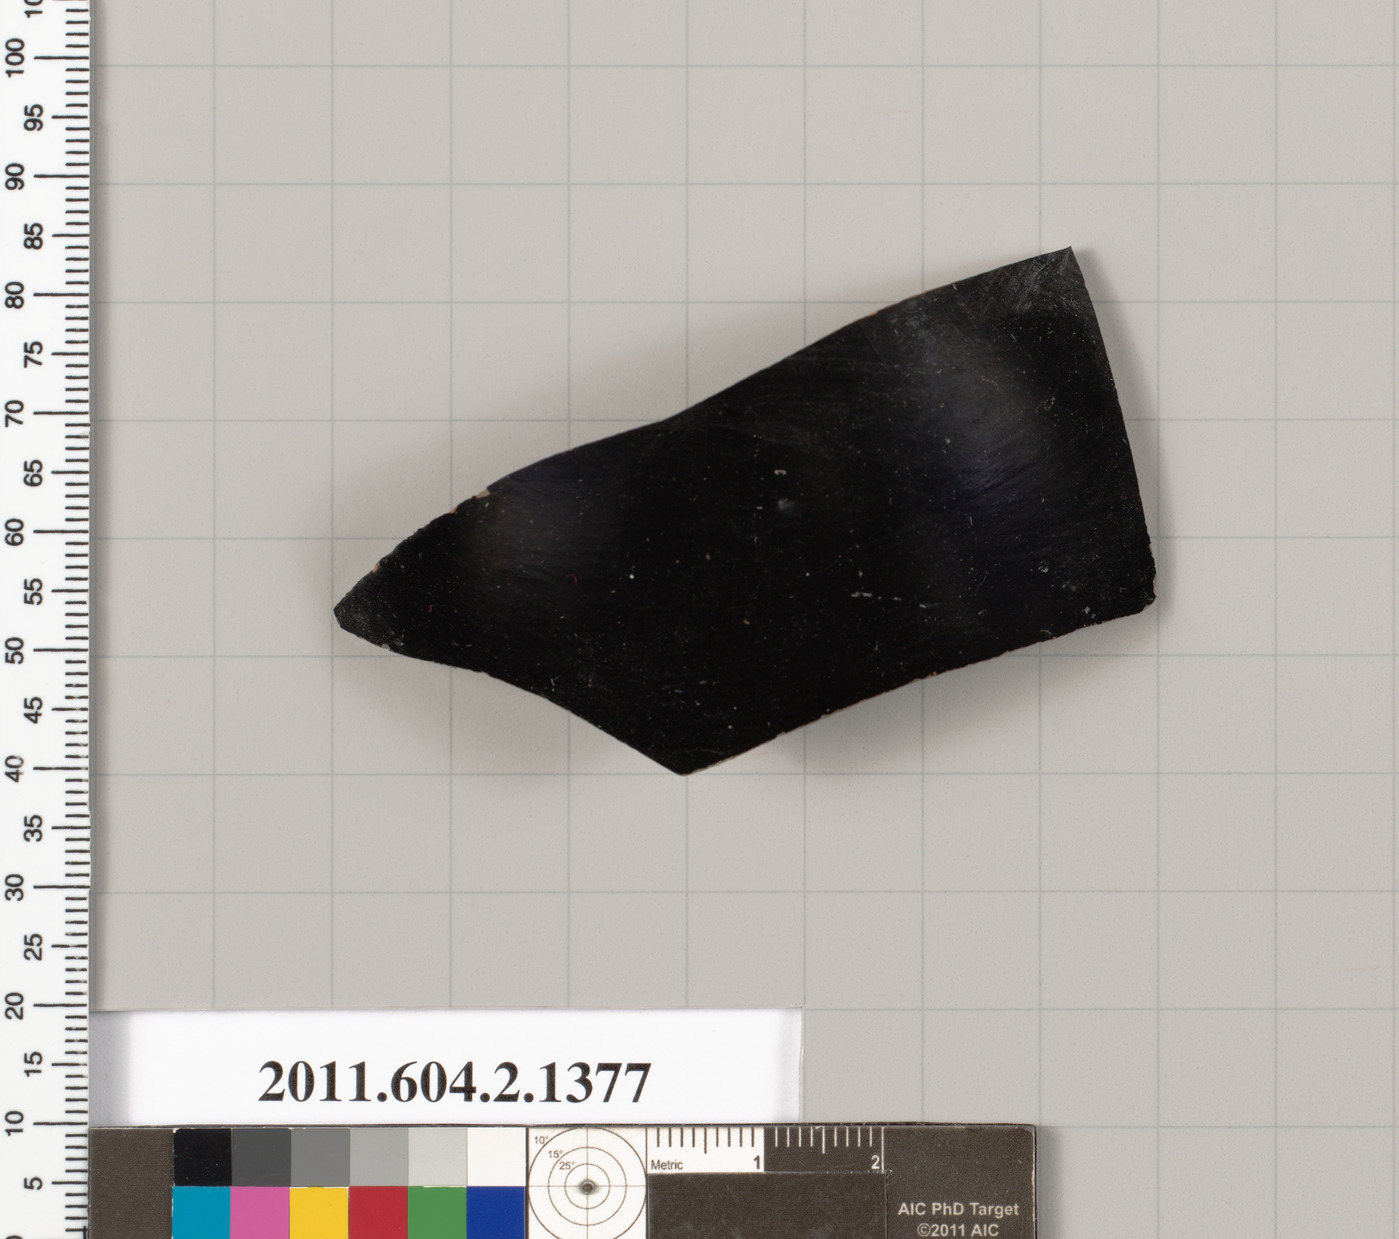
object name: skyphos fragment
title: Terracotta fragment of a skyphos (deep drinking cup)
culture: greek, attic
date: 475-451 BCE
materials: terracotta